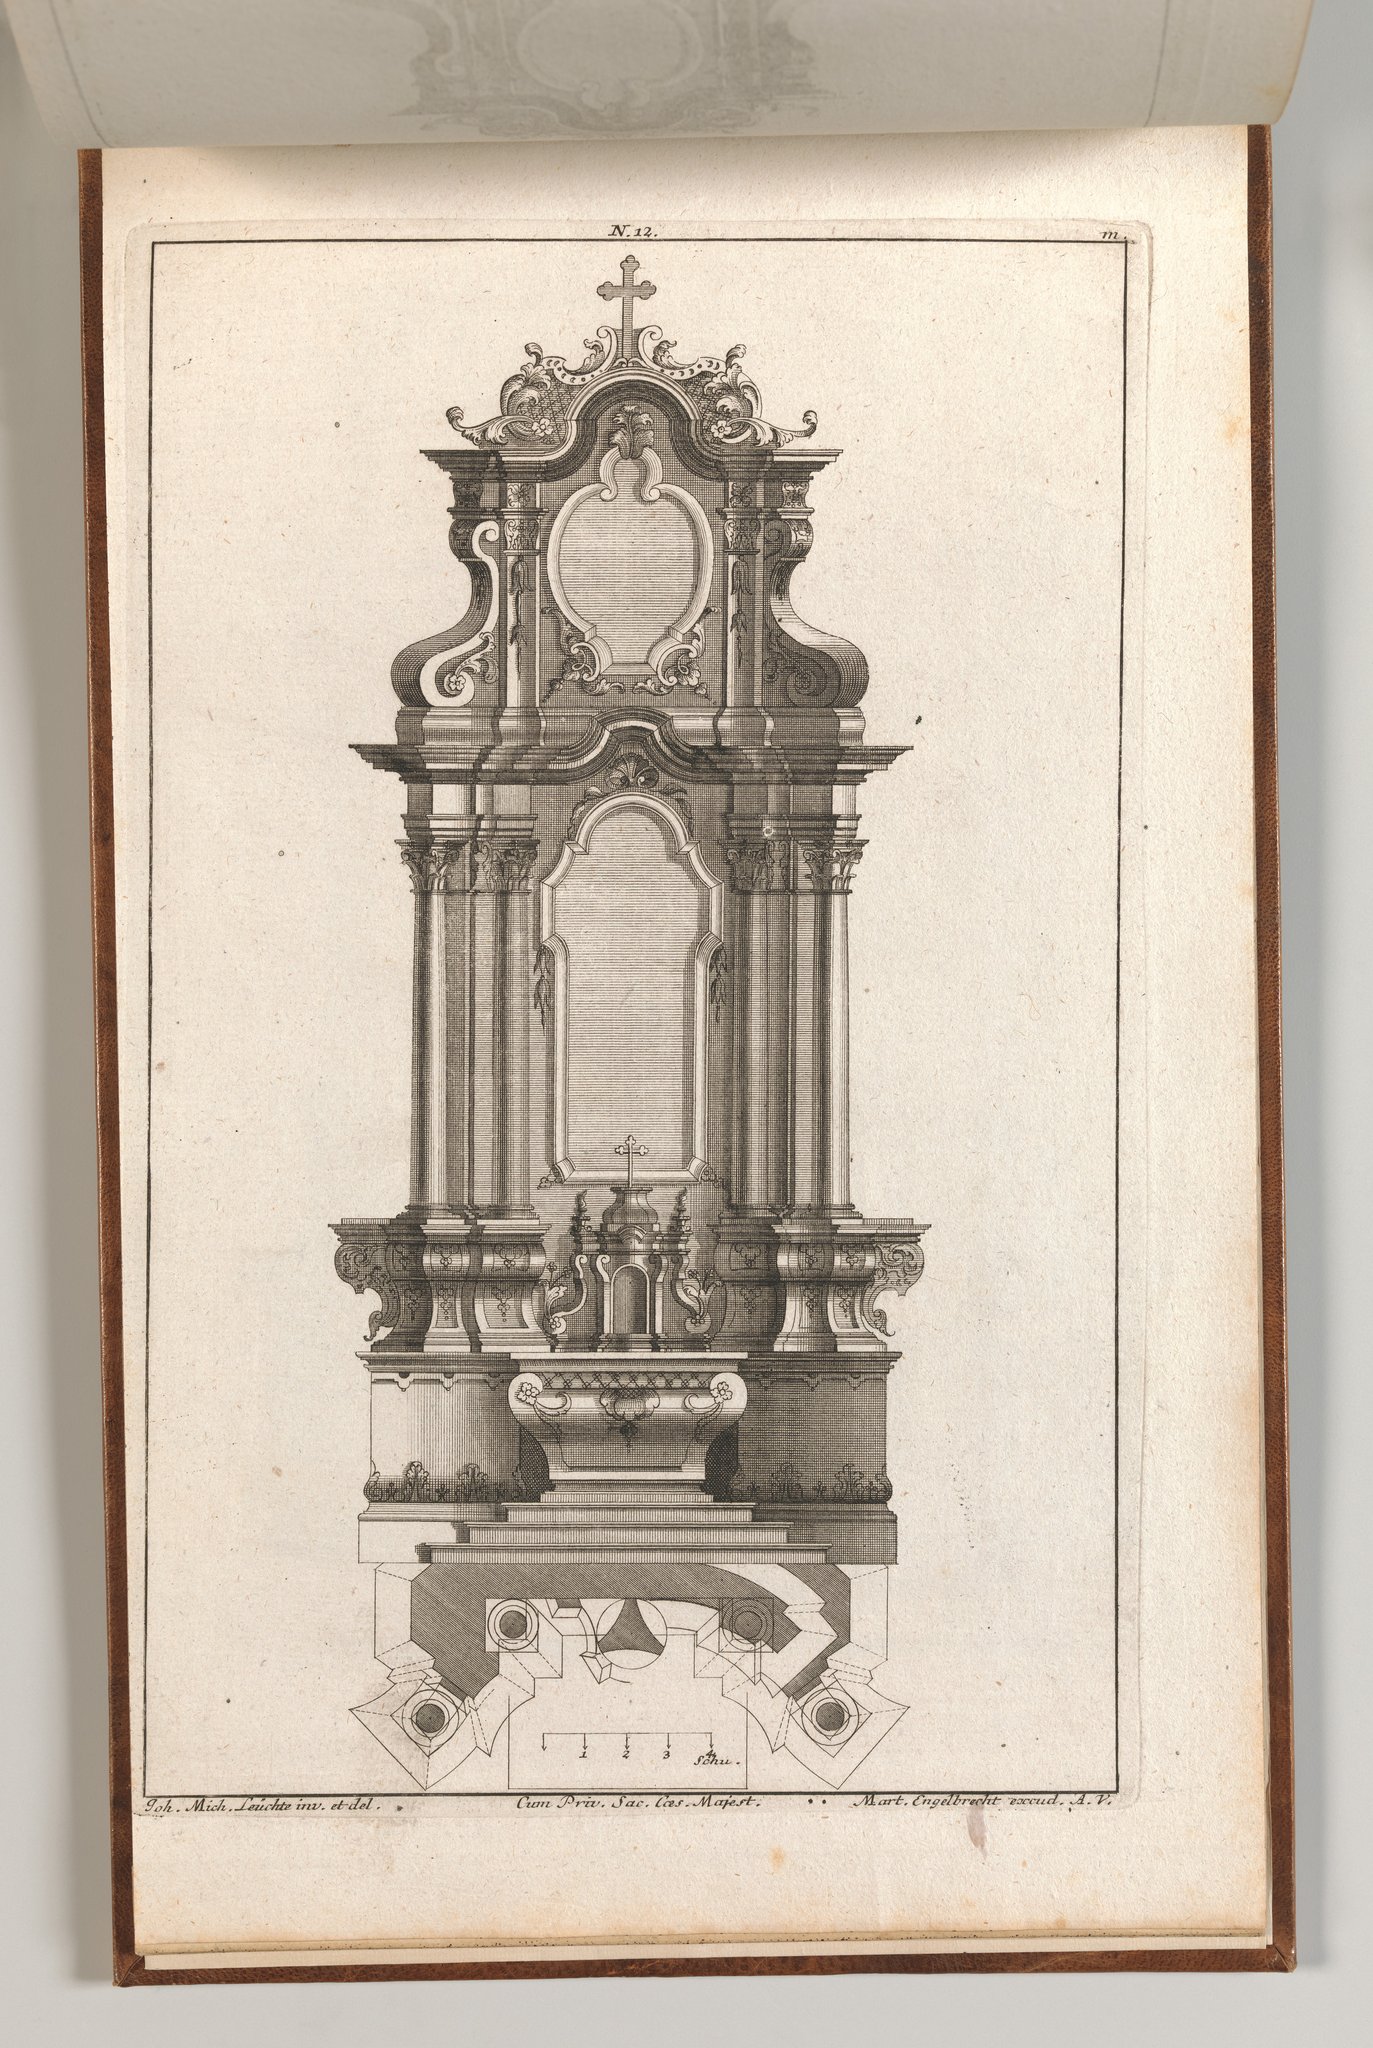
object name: album print ornament architecture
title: Design for a Monumental Altar, Plate m from 'Unterschiedliche Neu Inventierte Altäre mit darzu gehörigen Profillen u. Grundrißen.'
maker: johann michael leüchte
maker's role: artist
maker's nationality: german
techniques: etching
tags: altars